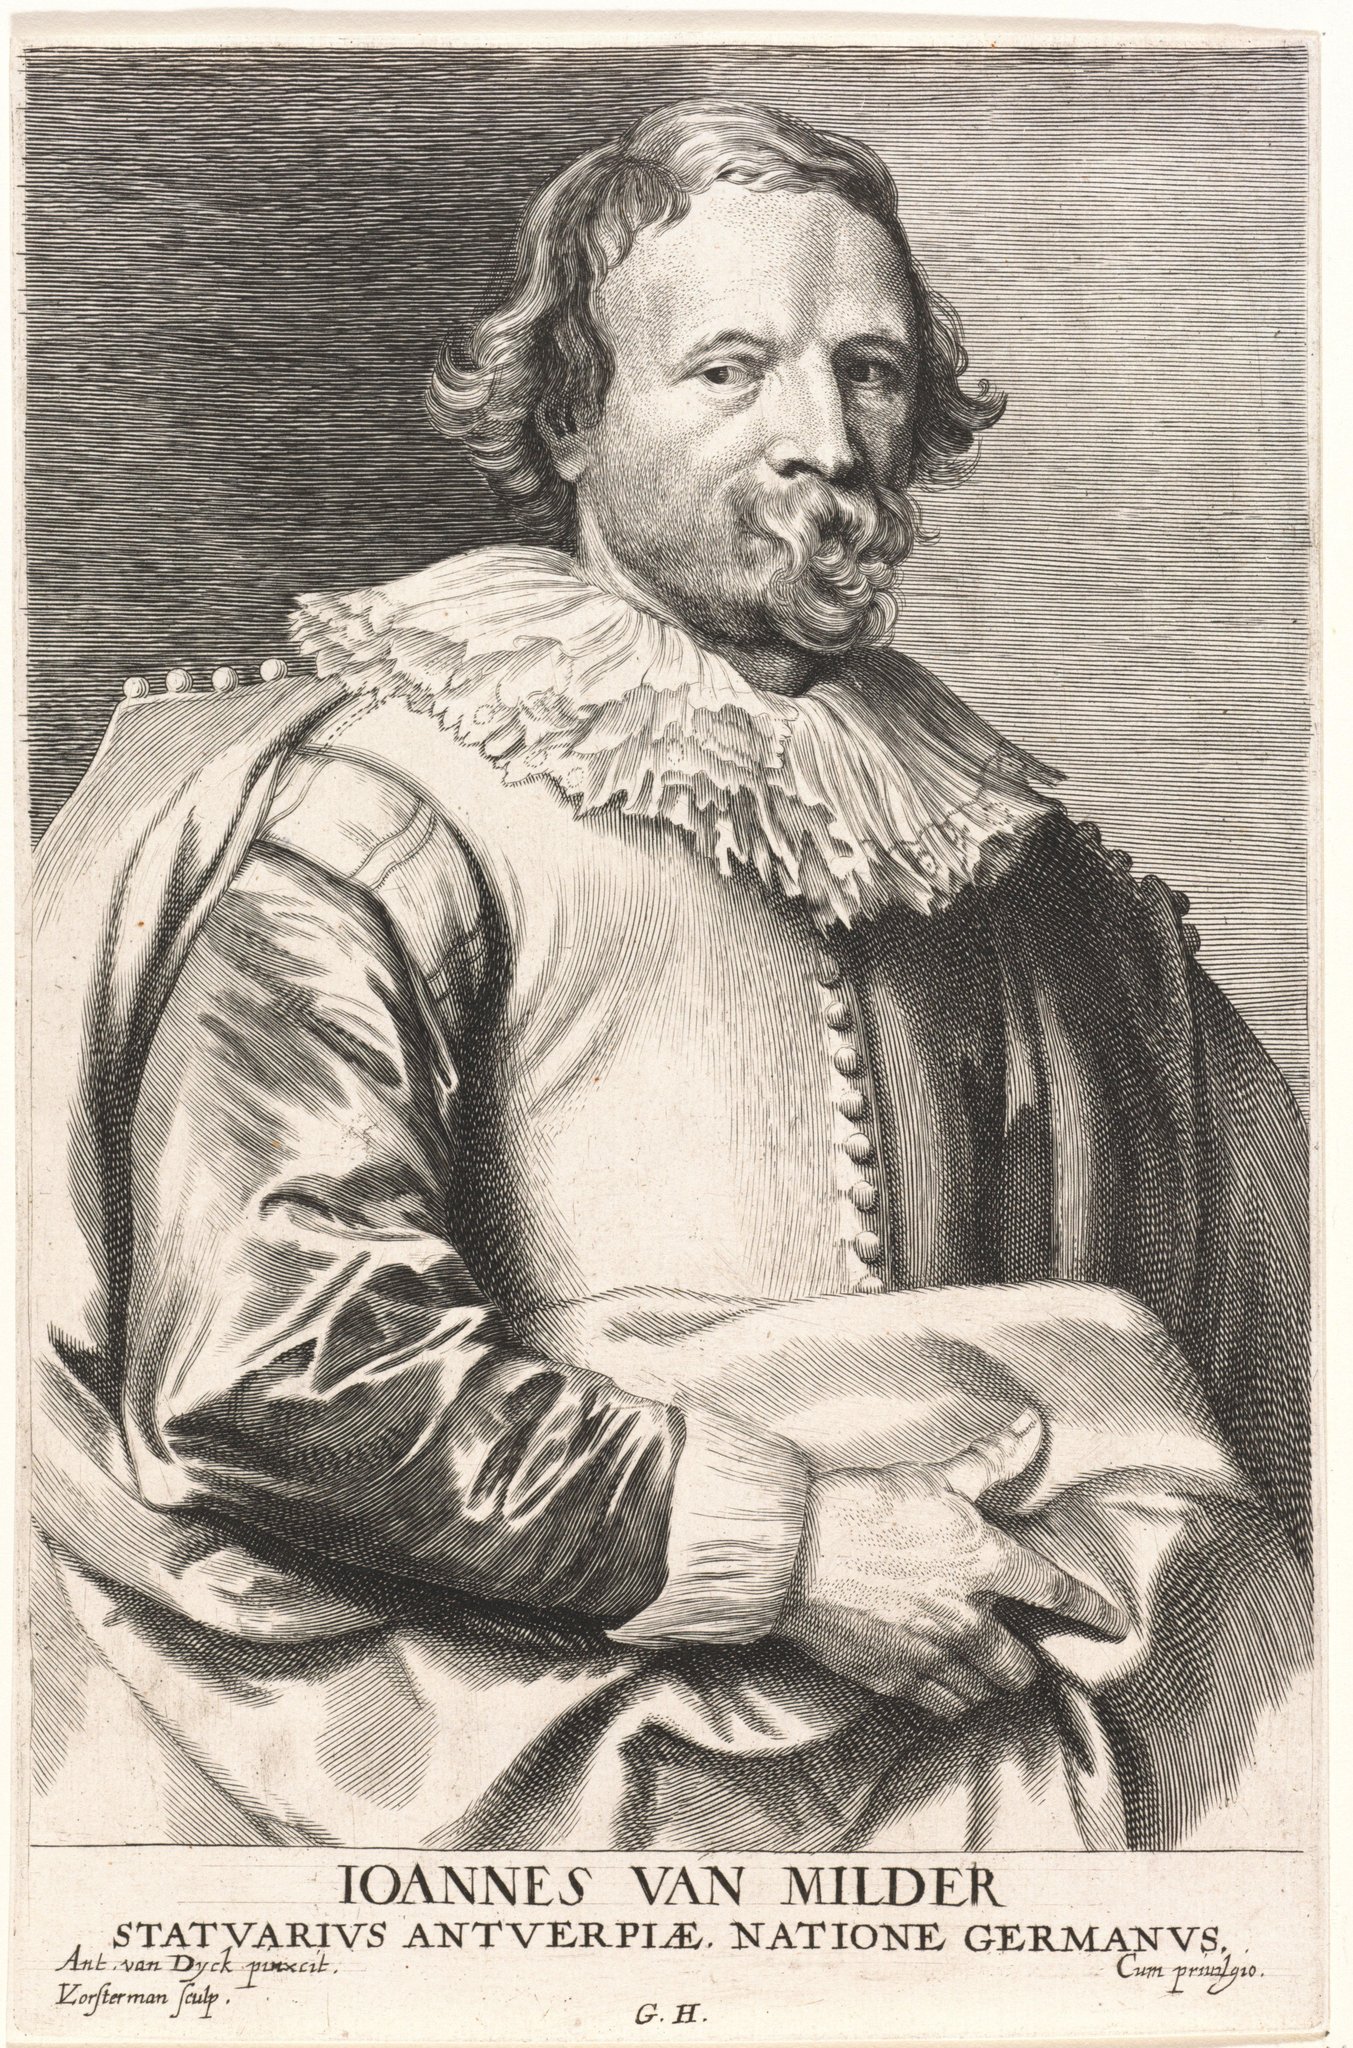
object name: print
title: Iconographie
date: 1645-1646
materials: paper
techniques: engraving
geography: antwerp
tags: sculptor, johannes van mildert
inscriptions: collector's mark: Lugt 240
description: Prent gebruikt voor: Icones principum, virorum doctorum, pictorum, chalcographorum, statuariorum nec non amatorum pictoriae artis numero centum ab Ant. van Dyck ad vivum expressae ejusque sumptibus aeri incisae. Antwerpen: Gillis Hendricx, [1645-1646].